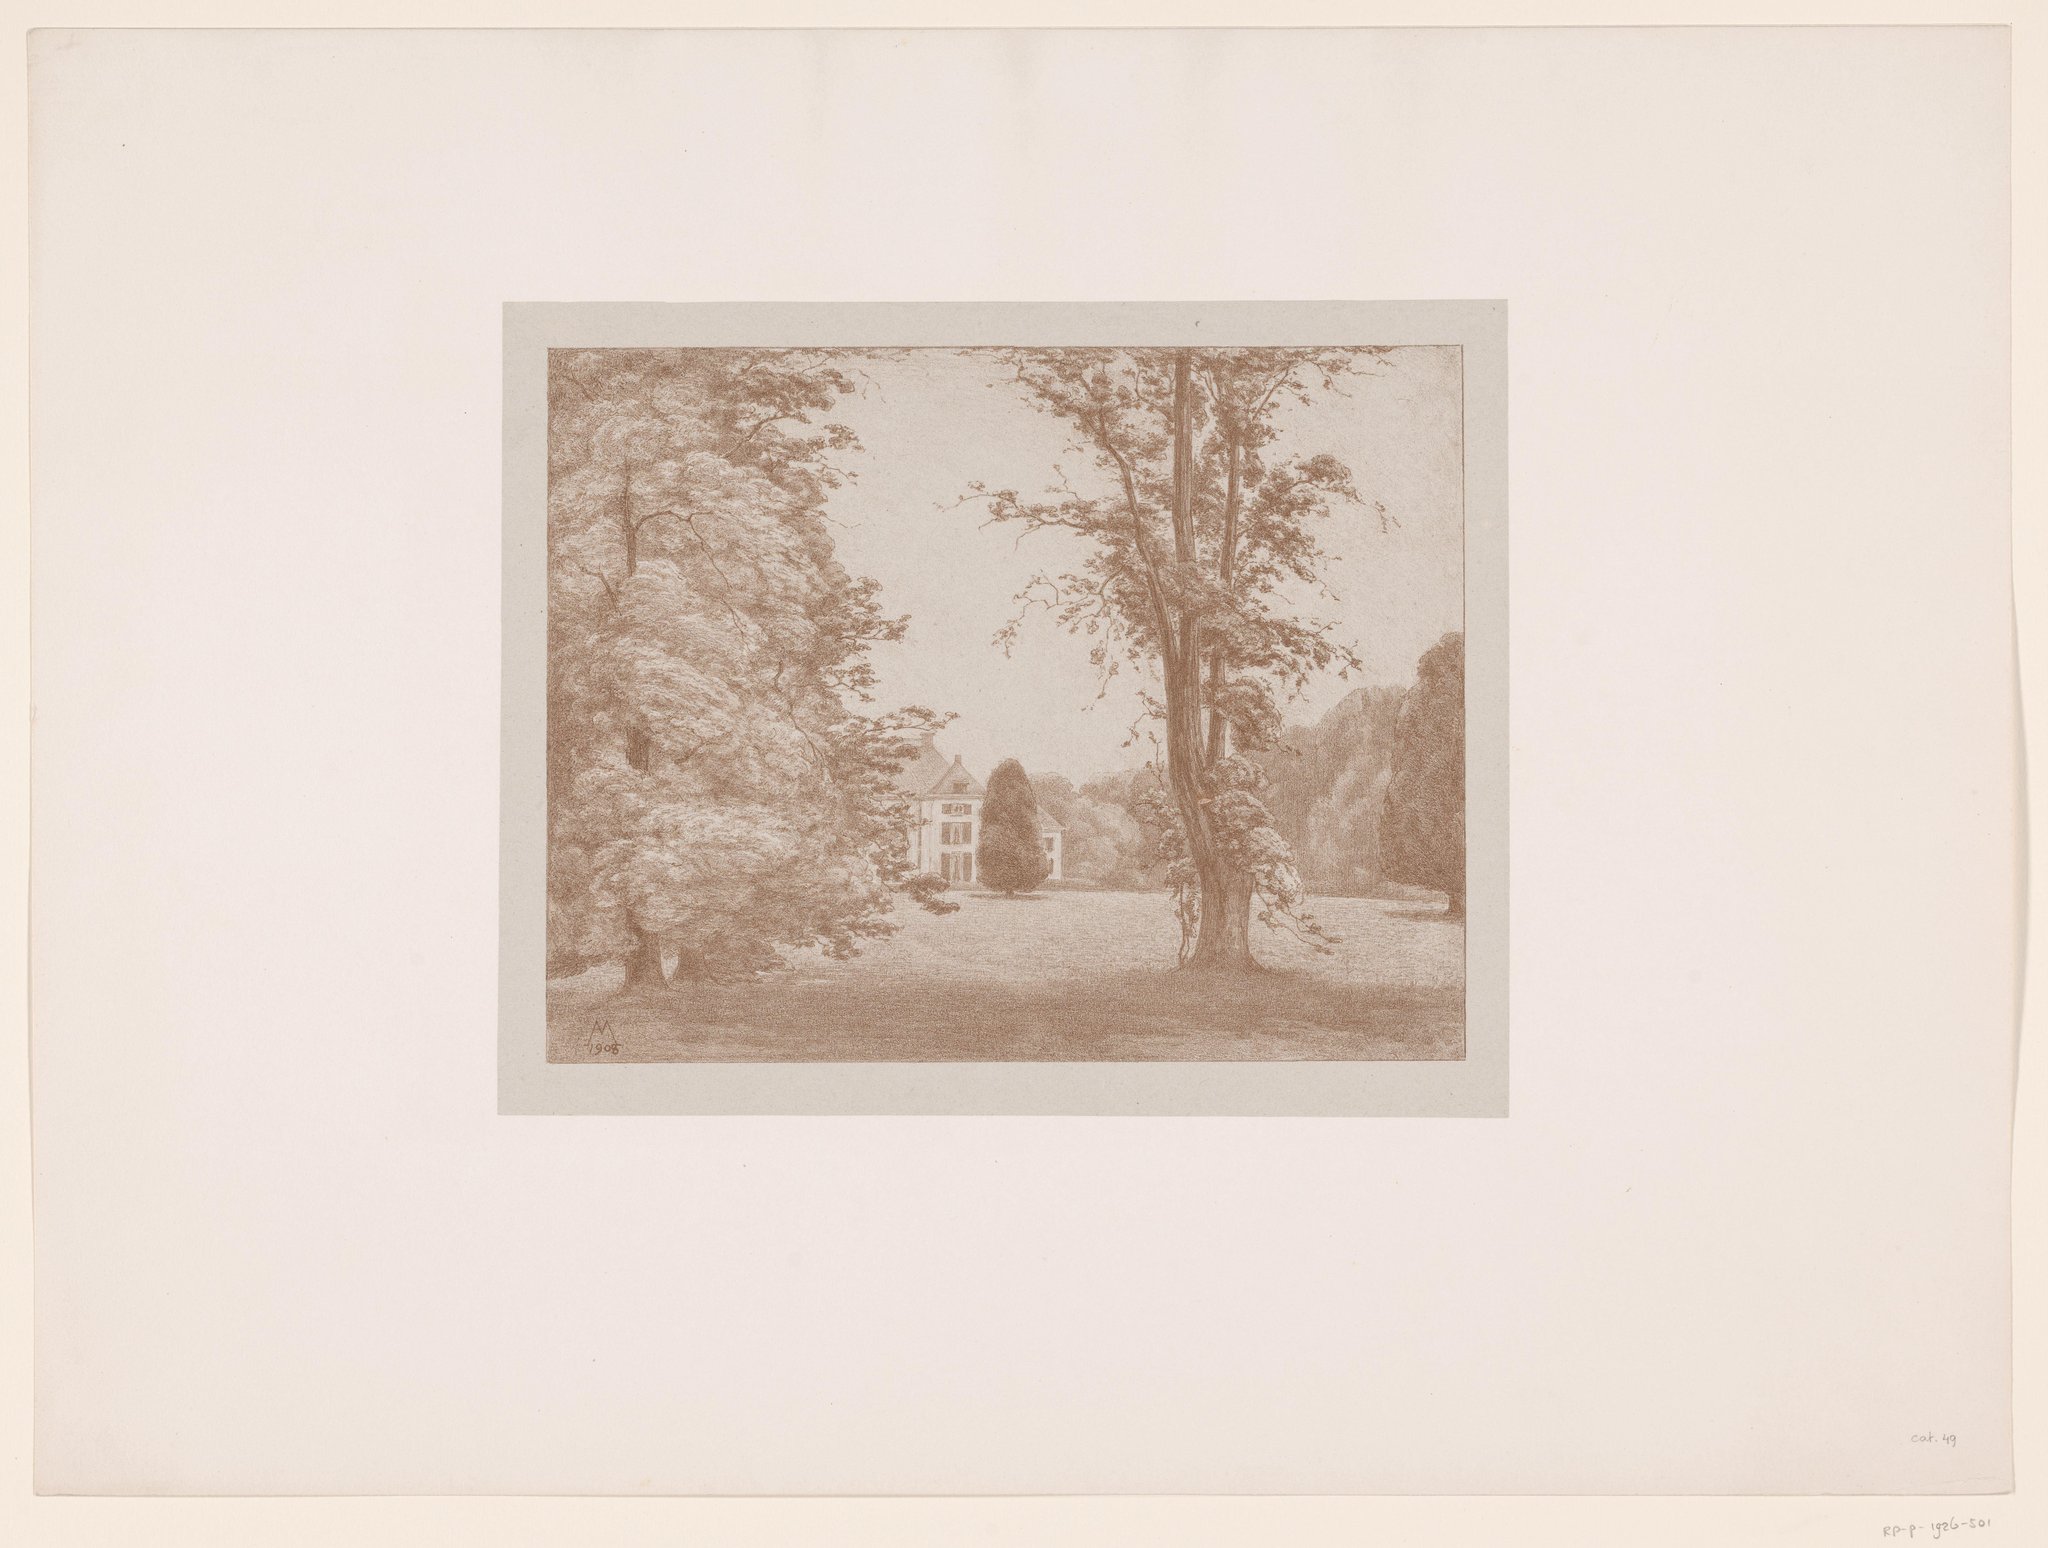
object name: print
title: Achterzijde van het paleis (linkervleugel)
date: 1908-1909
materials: paper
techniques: lithograph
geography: amsterdam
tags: palace